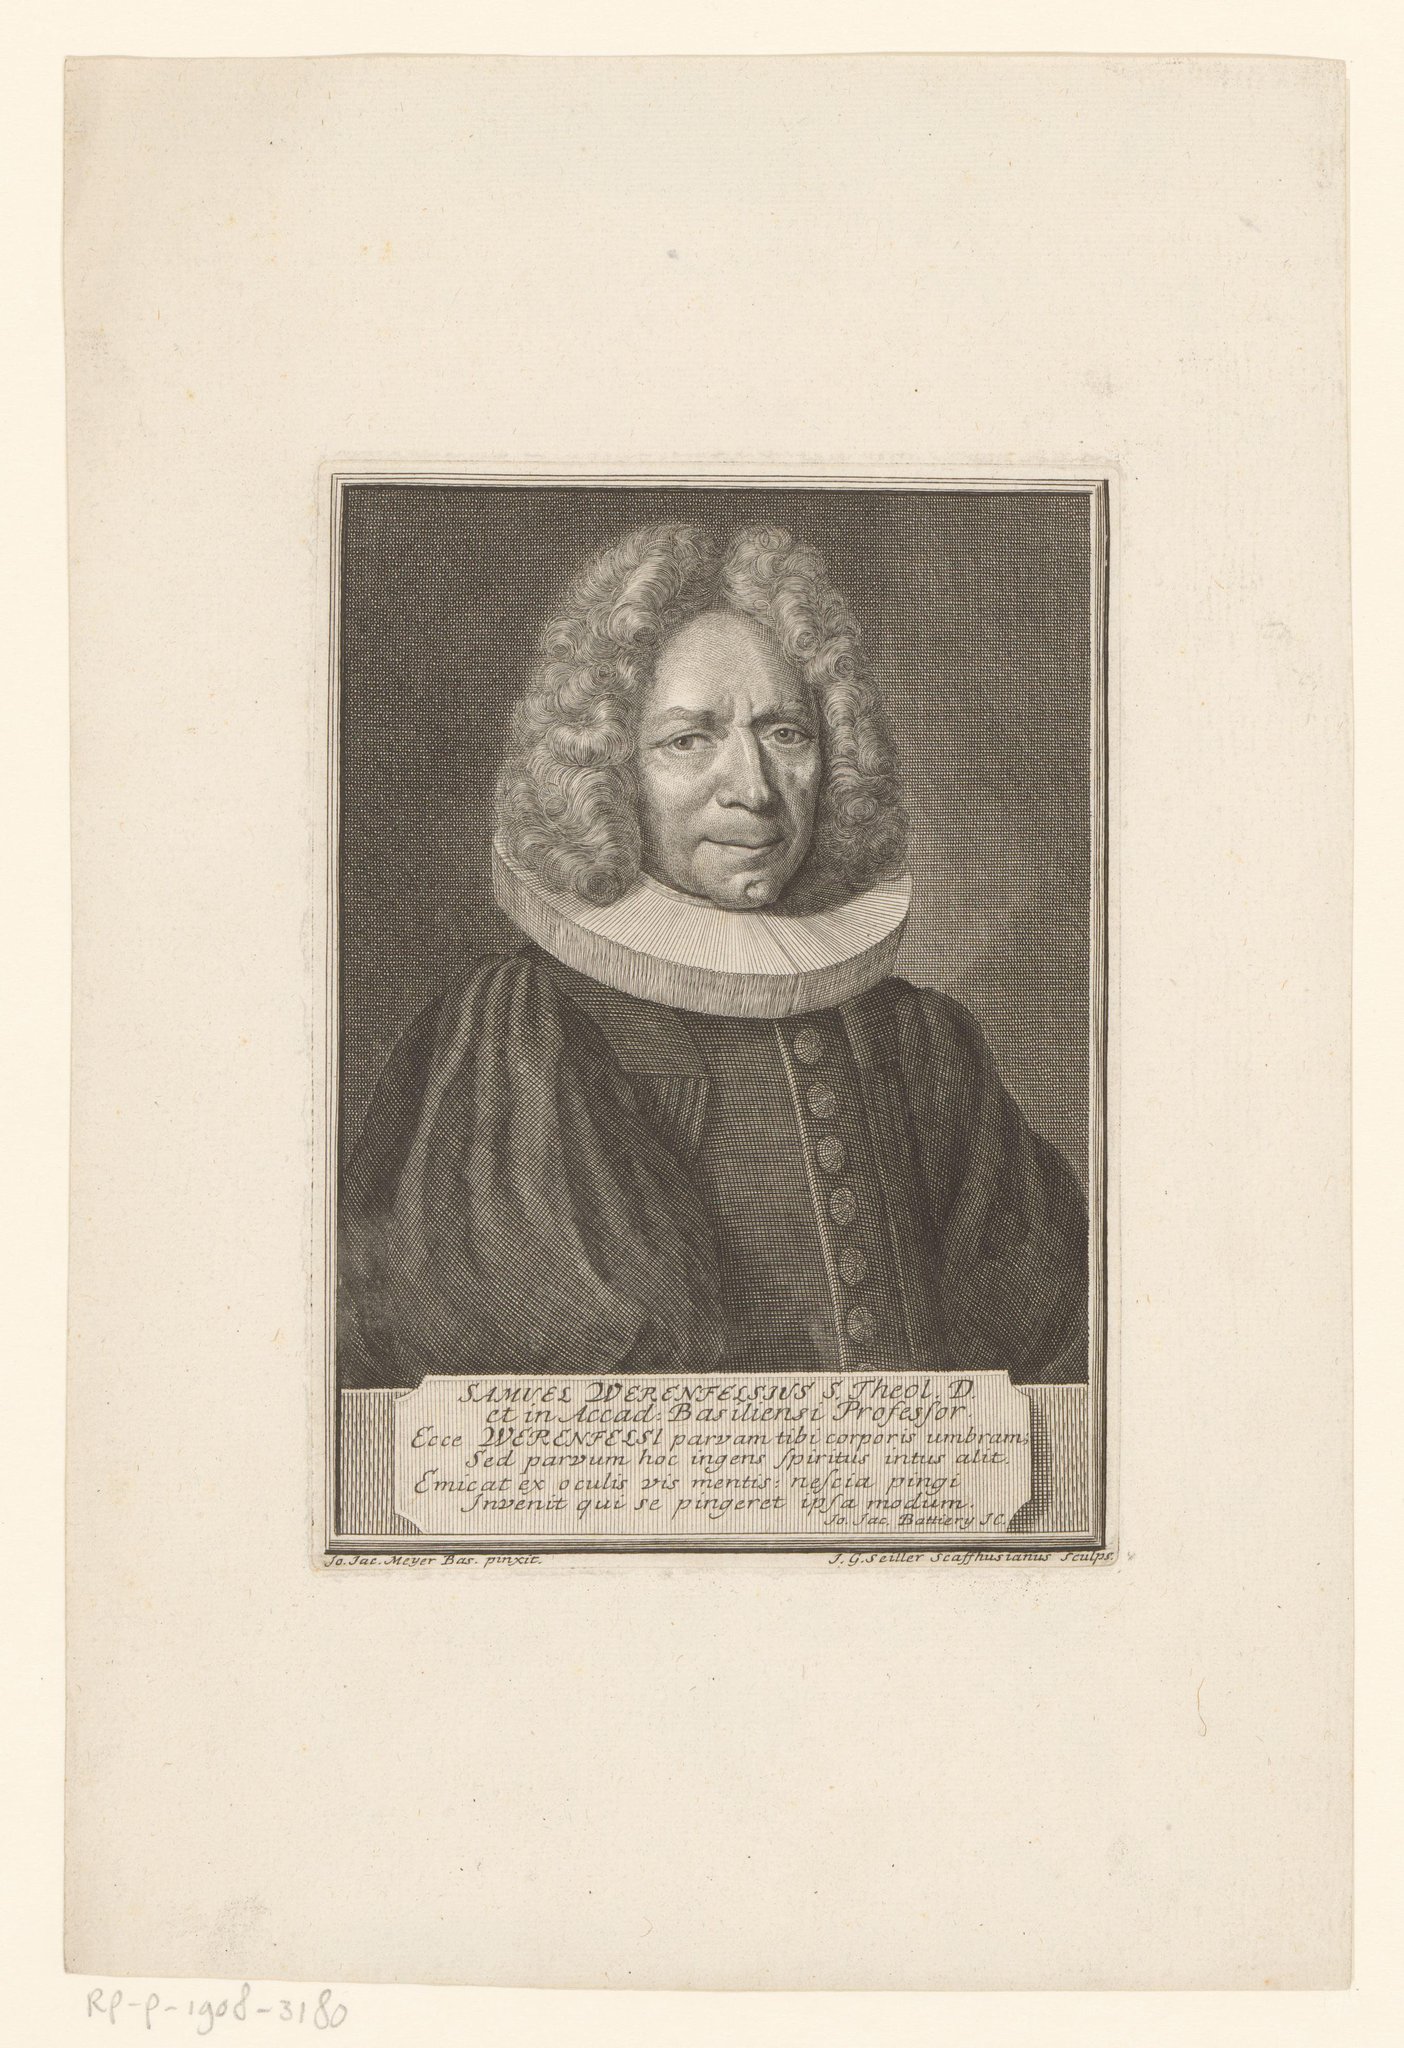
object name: print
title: Portret van Samuel Werenfels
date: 1673-1740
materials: paper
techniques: engraving, etching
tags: historical persons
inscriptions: collector's mark: Lugt 2228